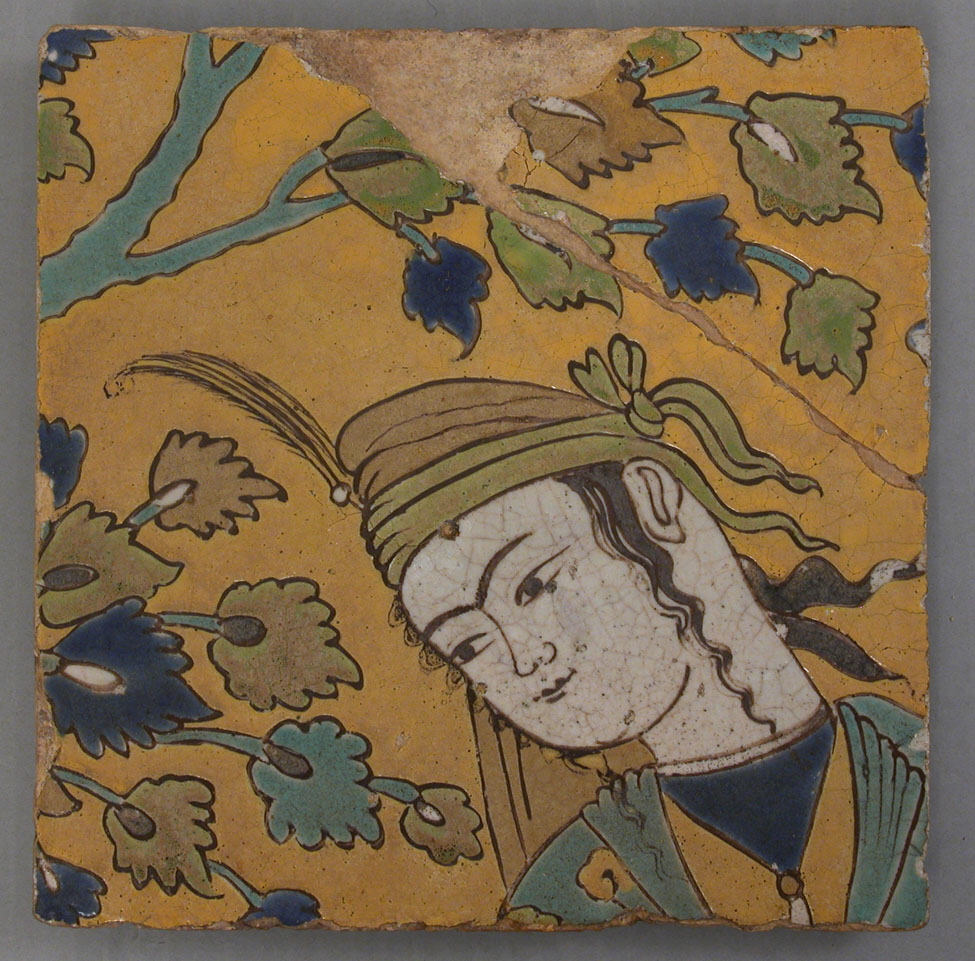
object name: tile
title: Tile Fragment of a Garden Scene Panel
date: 1601-1700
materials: glaze, stonepaste, wax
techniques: polychrome, resist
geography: iran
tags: men